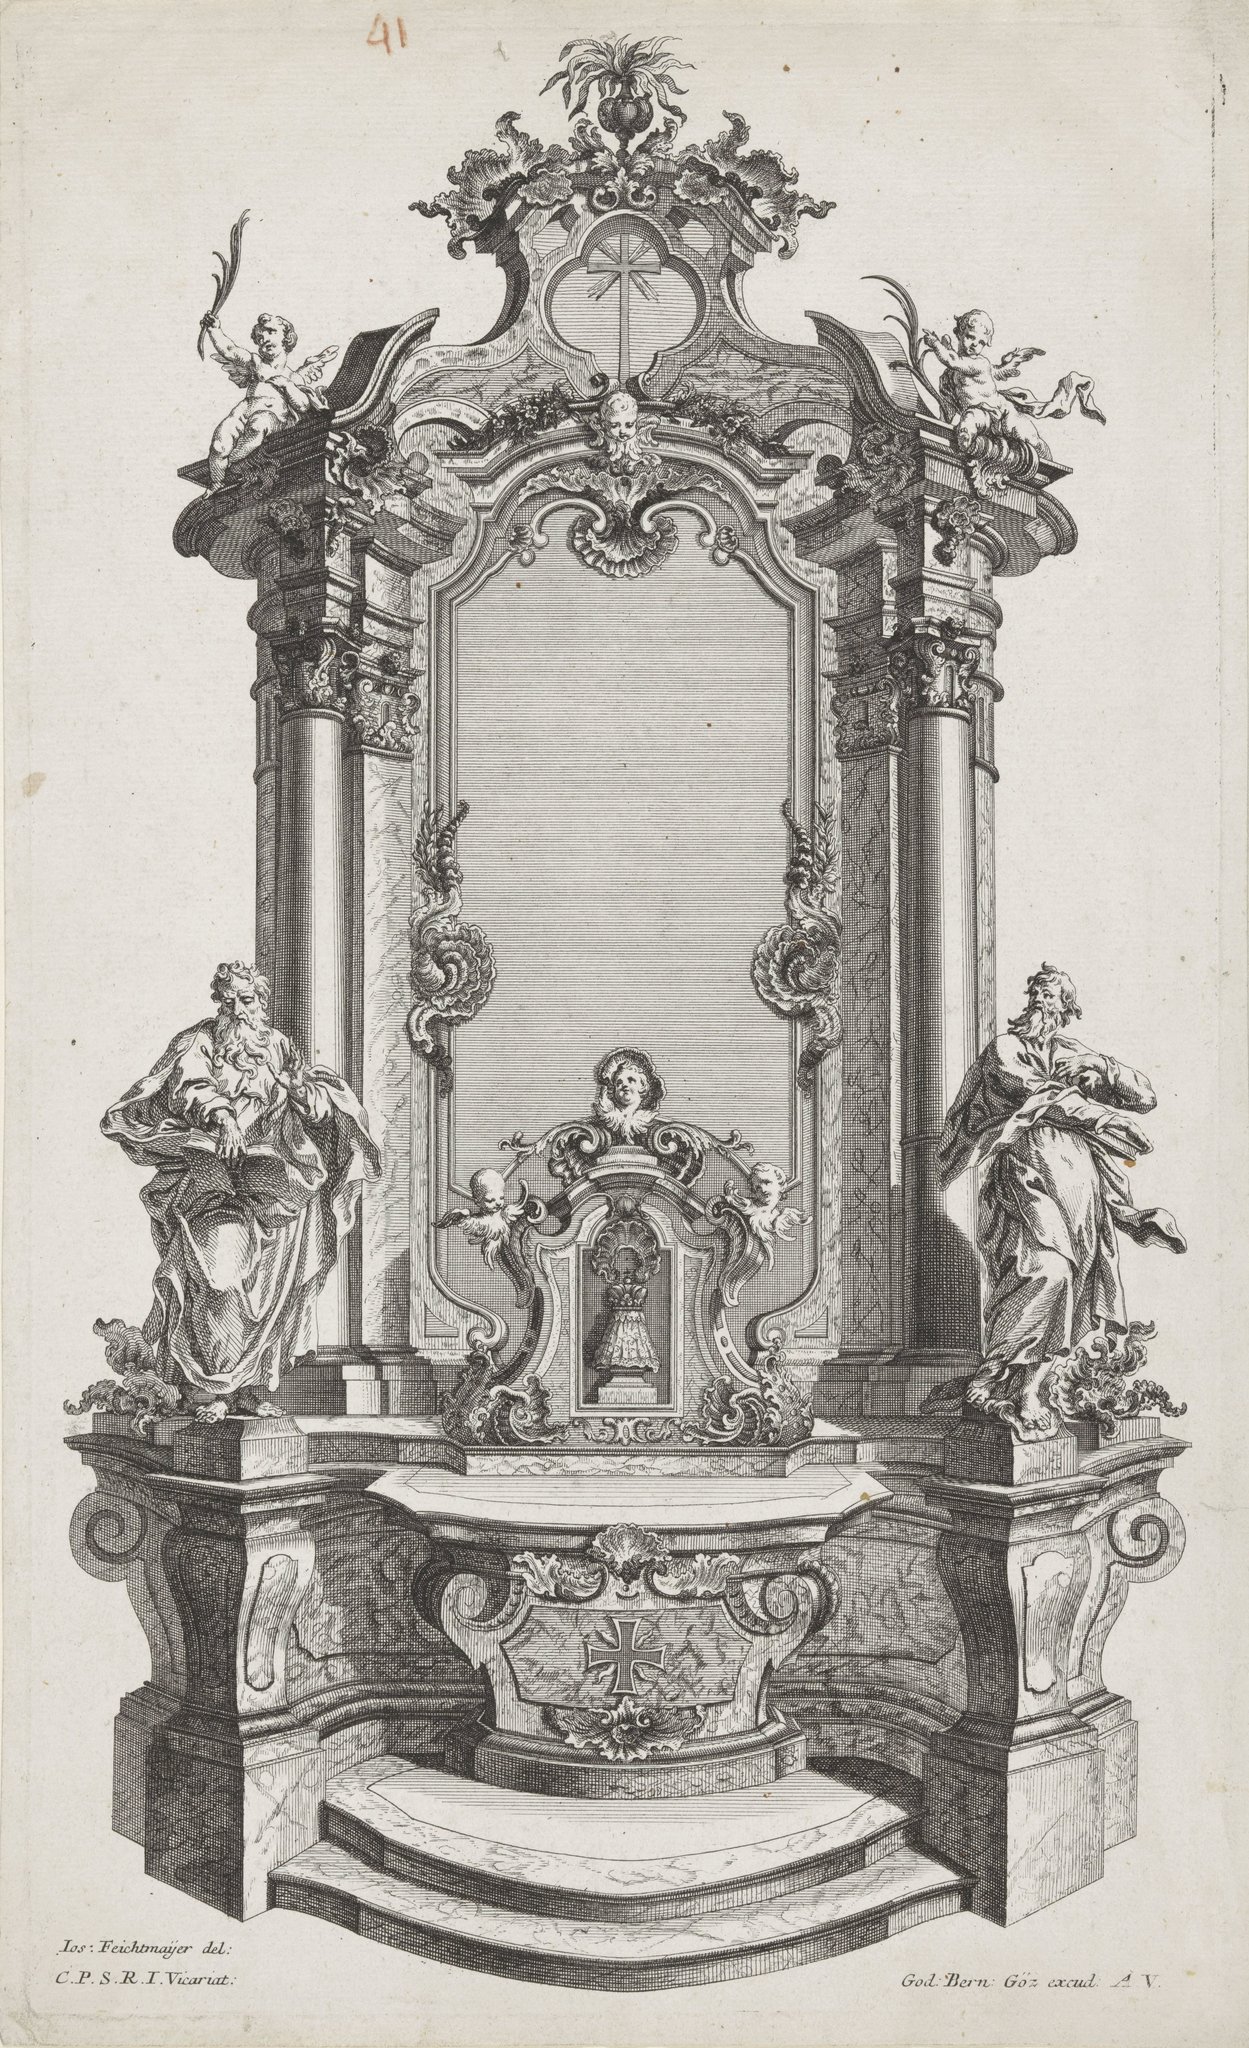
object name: print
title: Altäre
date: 1740-1745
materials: paper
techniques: engraving, etching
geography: augsburg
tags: standing figure, altar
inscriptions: collector's mark: Lugt 2228, collector's mark: Lugt 2760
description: Twee mannelijke figuren met een boek in hun hand staan links en rechts op een altaar met rocaille ornamenten. Twee engelen met palmtakken boven de pilaren van het altaar. Het altaar wordt afgesloten met een kruis in een vierpas.